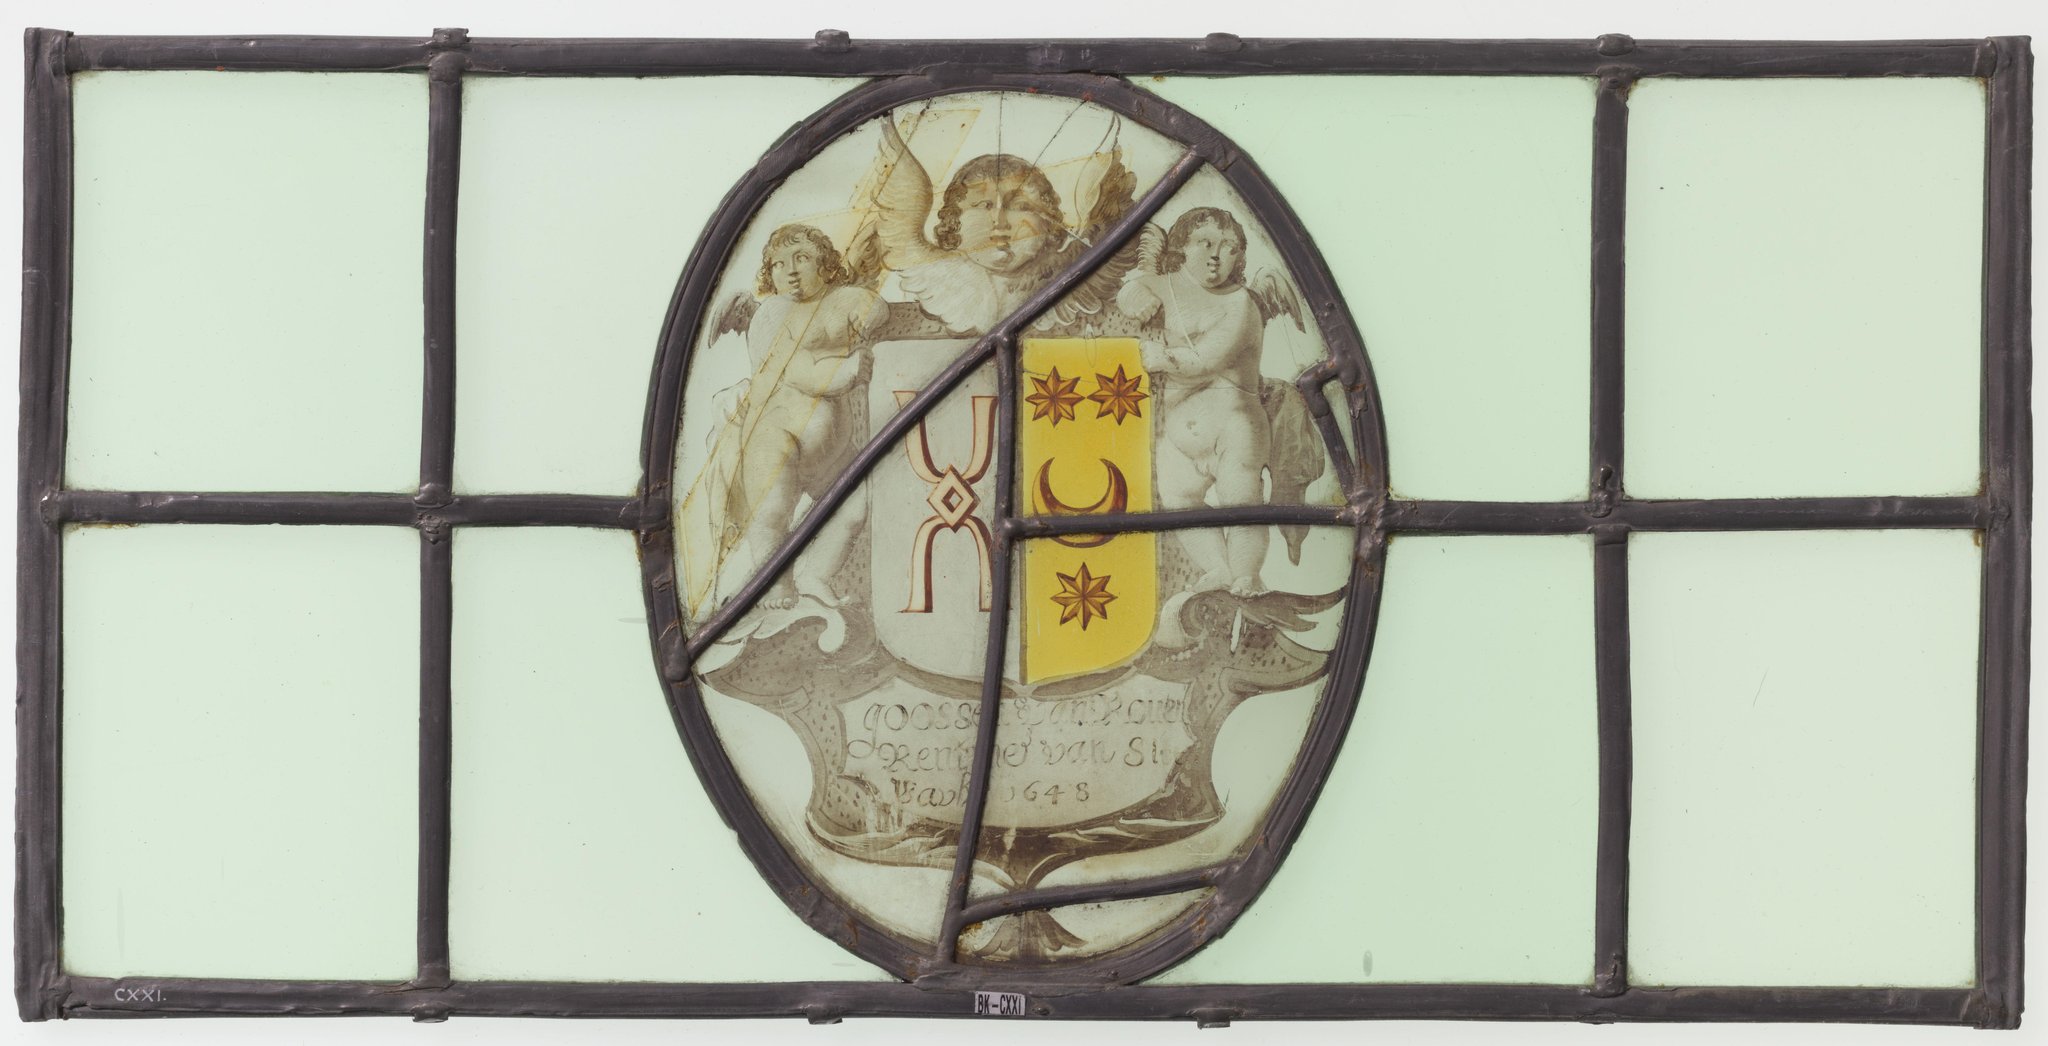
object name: light window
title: Ruit met wapenschild met onderschrift "Joossen Van Rouen ... 1648"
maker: Anonymous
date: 1648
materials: glass, lead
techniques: leading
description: Ovale wapenruit met onder het wapenschild de tekst: JOOSSEN VAN ROUEN. ... 1648. Omgeven door cartouche en twee engelen en grisaille.